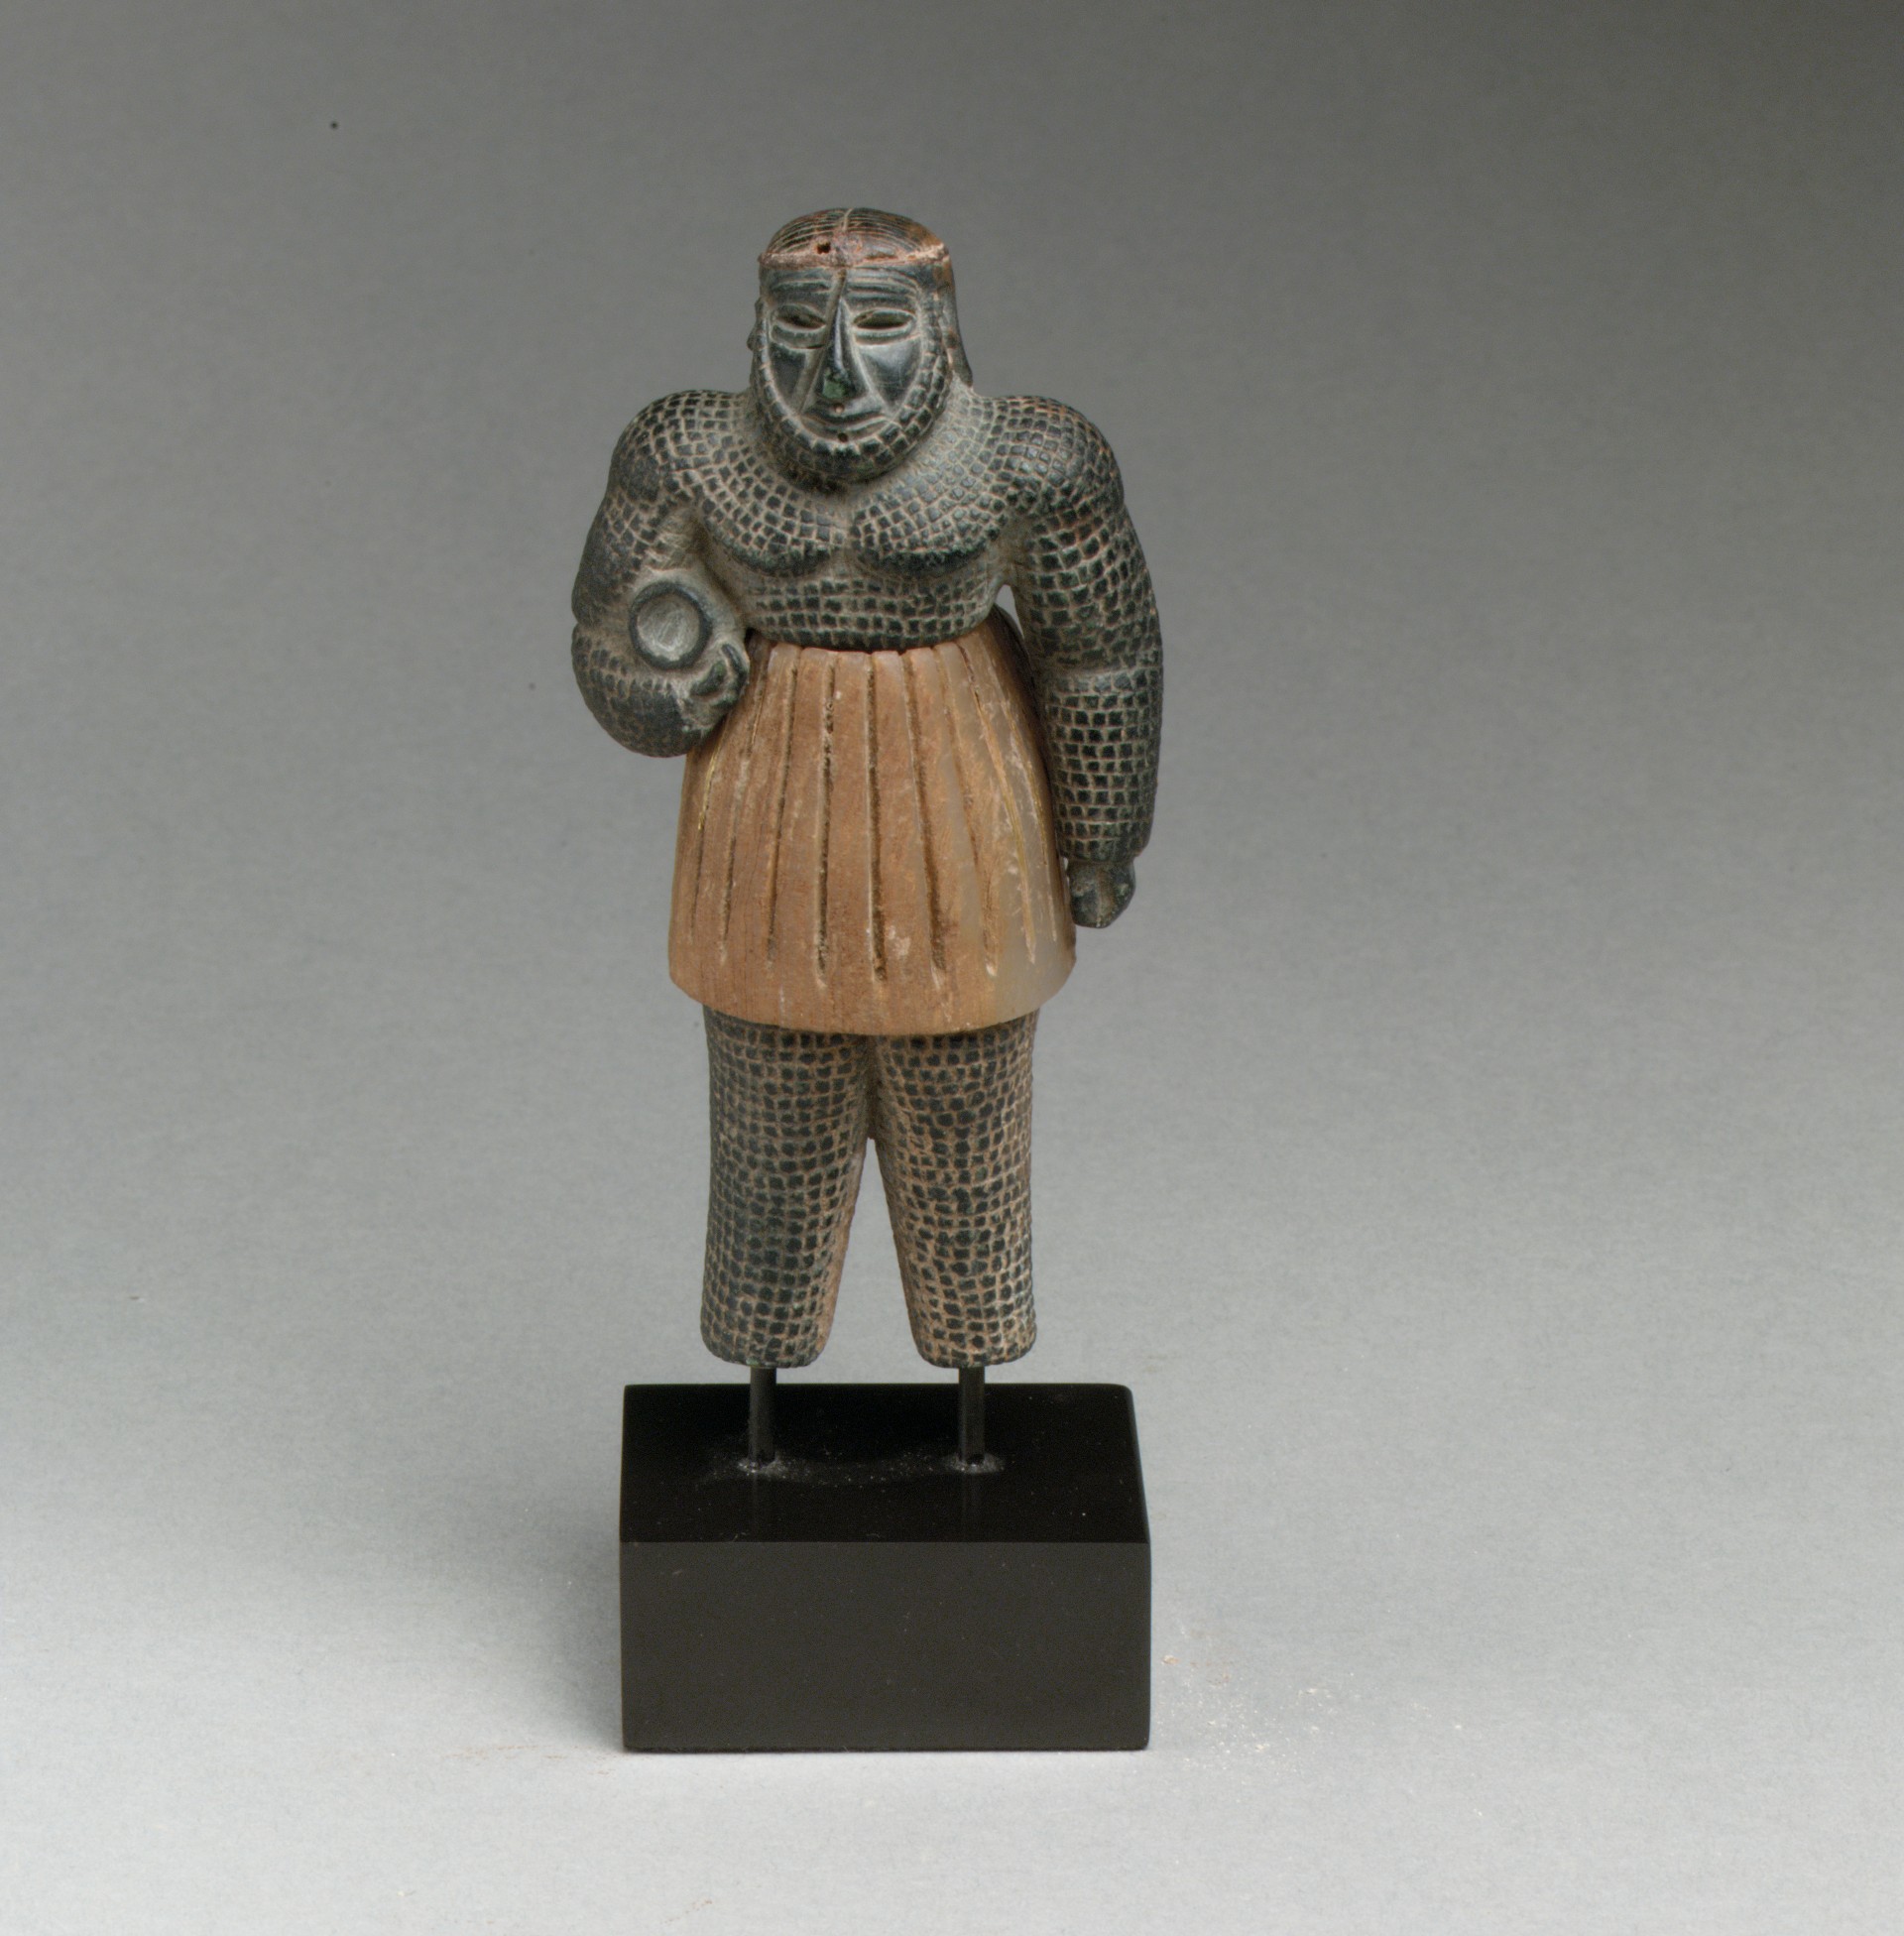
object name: sculpture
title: Monstrous male figure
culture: bactria-margiana archaeological complex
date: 2333-1668 BCE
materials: mineral, gold, iron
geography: bactria-margiana or eastern iran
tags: men